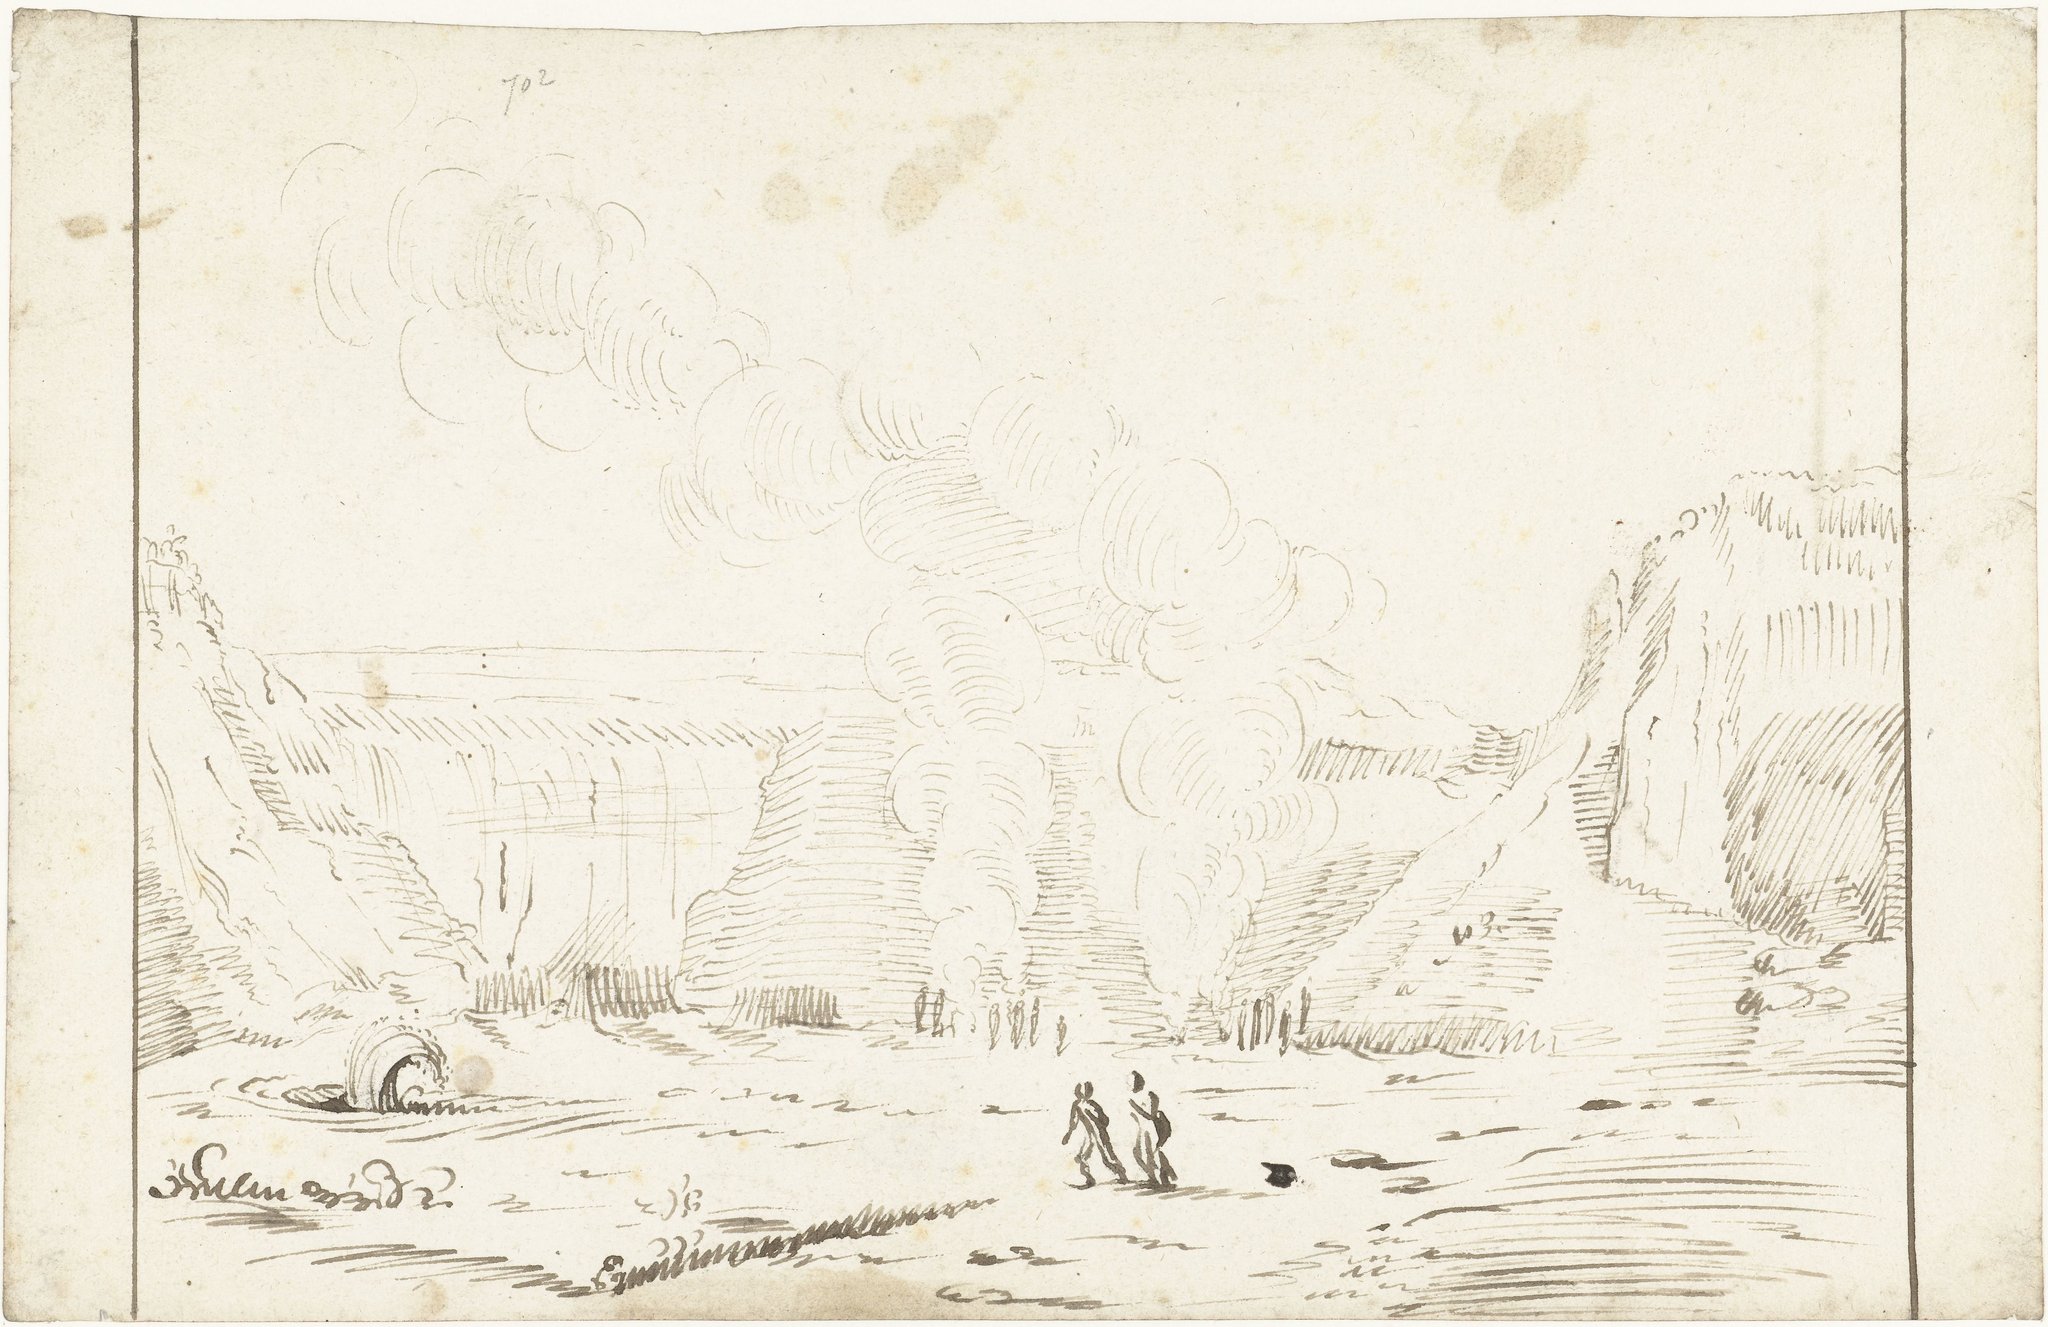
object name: drawing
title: Schets van de Solfatara bij Pozzuoli, buiten Napels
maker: gerard ter borch (i)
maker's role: draughtsman, print maker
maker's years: 1584-1662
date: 1611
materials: ink, paper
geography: pozzuoli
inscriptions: annotation: ‘182’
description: p. 182 van een schetsboek of een serie, zoals aangegeven in notities van Gerard (I).